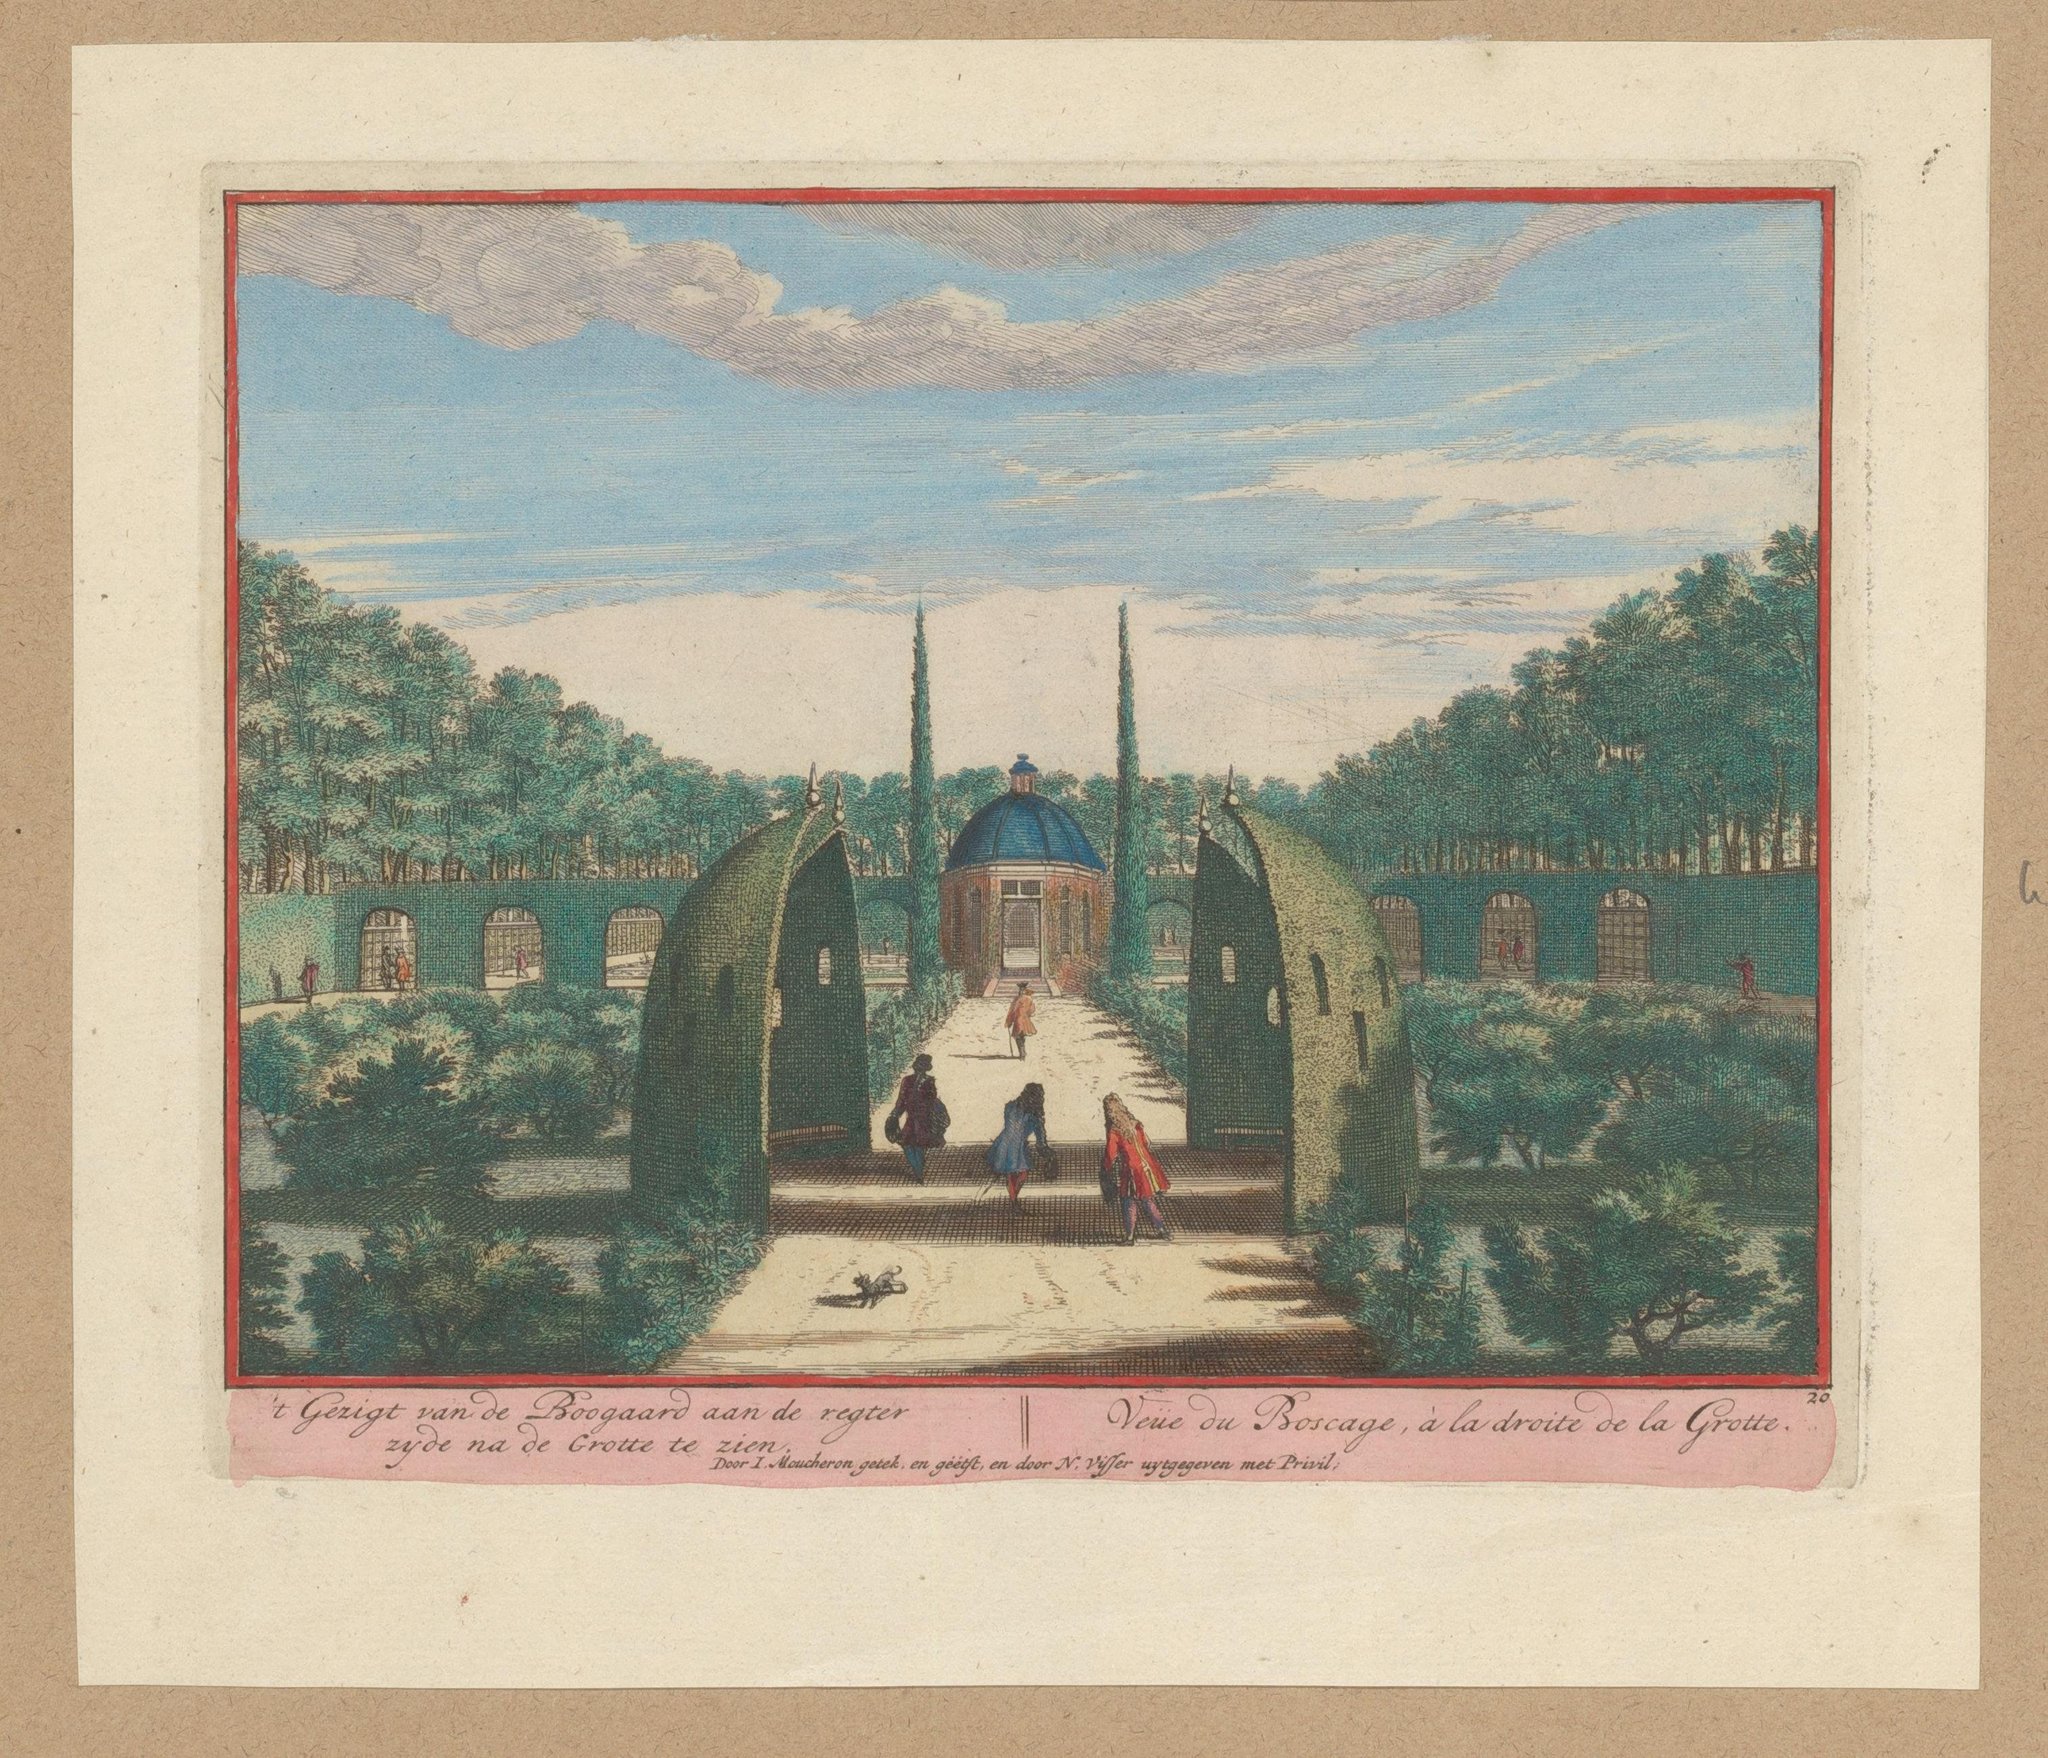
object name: print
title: Gezichten op Kasteel Heemstede in de provincie Utrecht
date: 1706-1719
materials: paper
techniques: engraving, etching, hand coloring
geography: amsterdam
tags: french or architectonic garden; formal garden, pergola, artificial grotto in garden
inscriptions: collector's mark: Lugt 1641, stamp, stamp, stamp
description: De boomgaard met aan het einde van de laan een grot. Rechtsonder genummerd: 20. Onderwerpsrubrieken binnen de Atlas Zeden en Gewoonten: Zeden en Gewoonten in Engeren Zin, De Woning, Oude Nederlandsche Tuinkunst, De 17de en 18de eeuw. Stadtuinen.